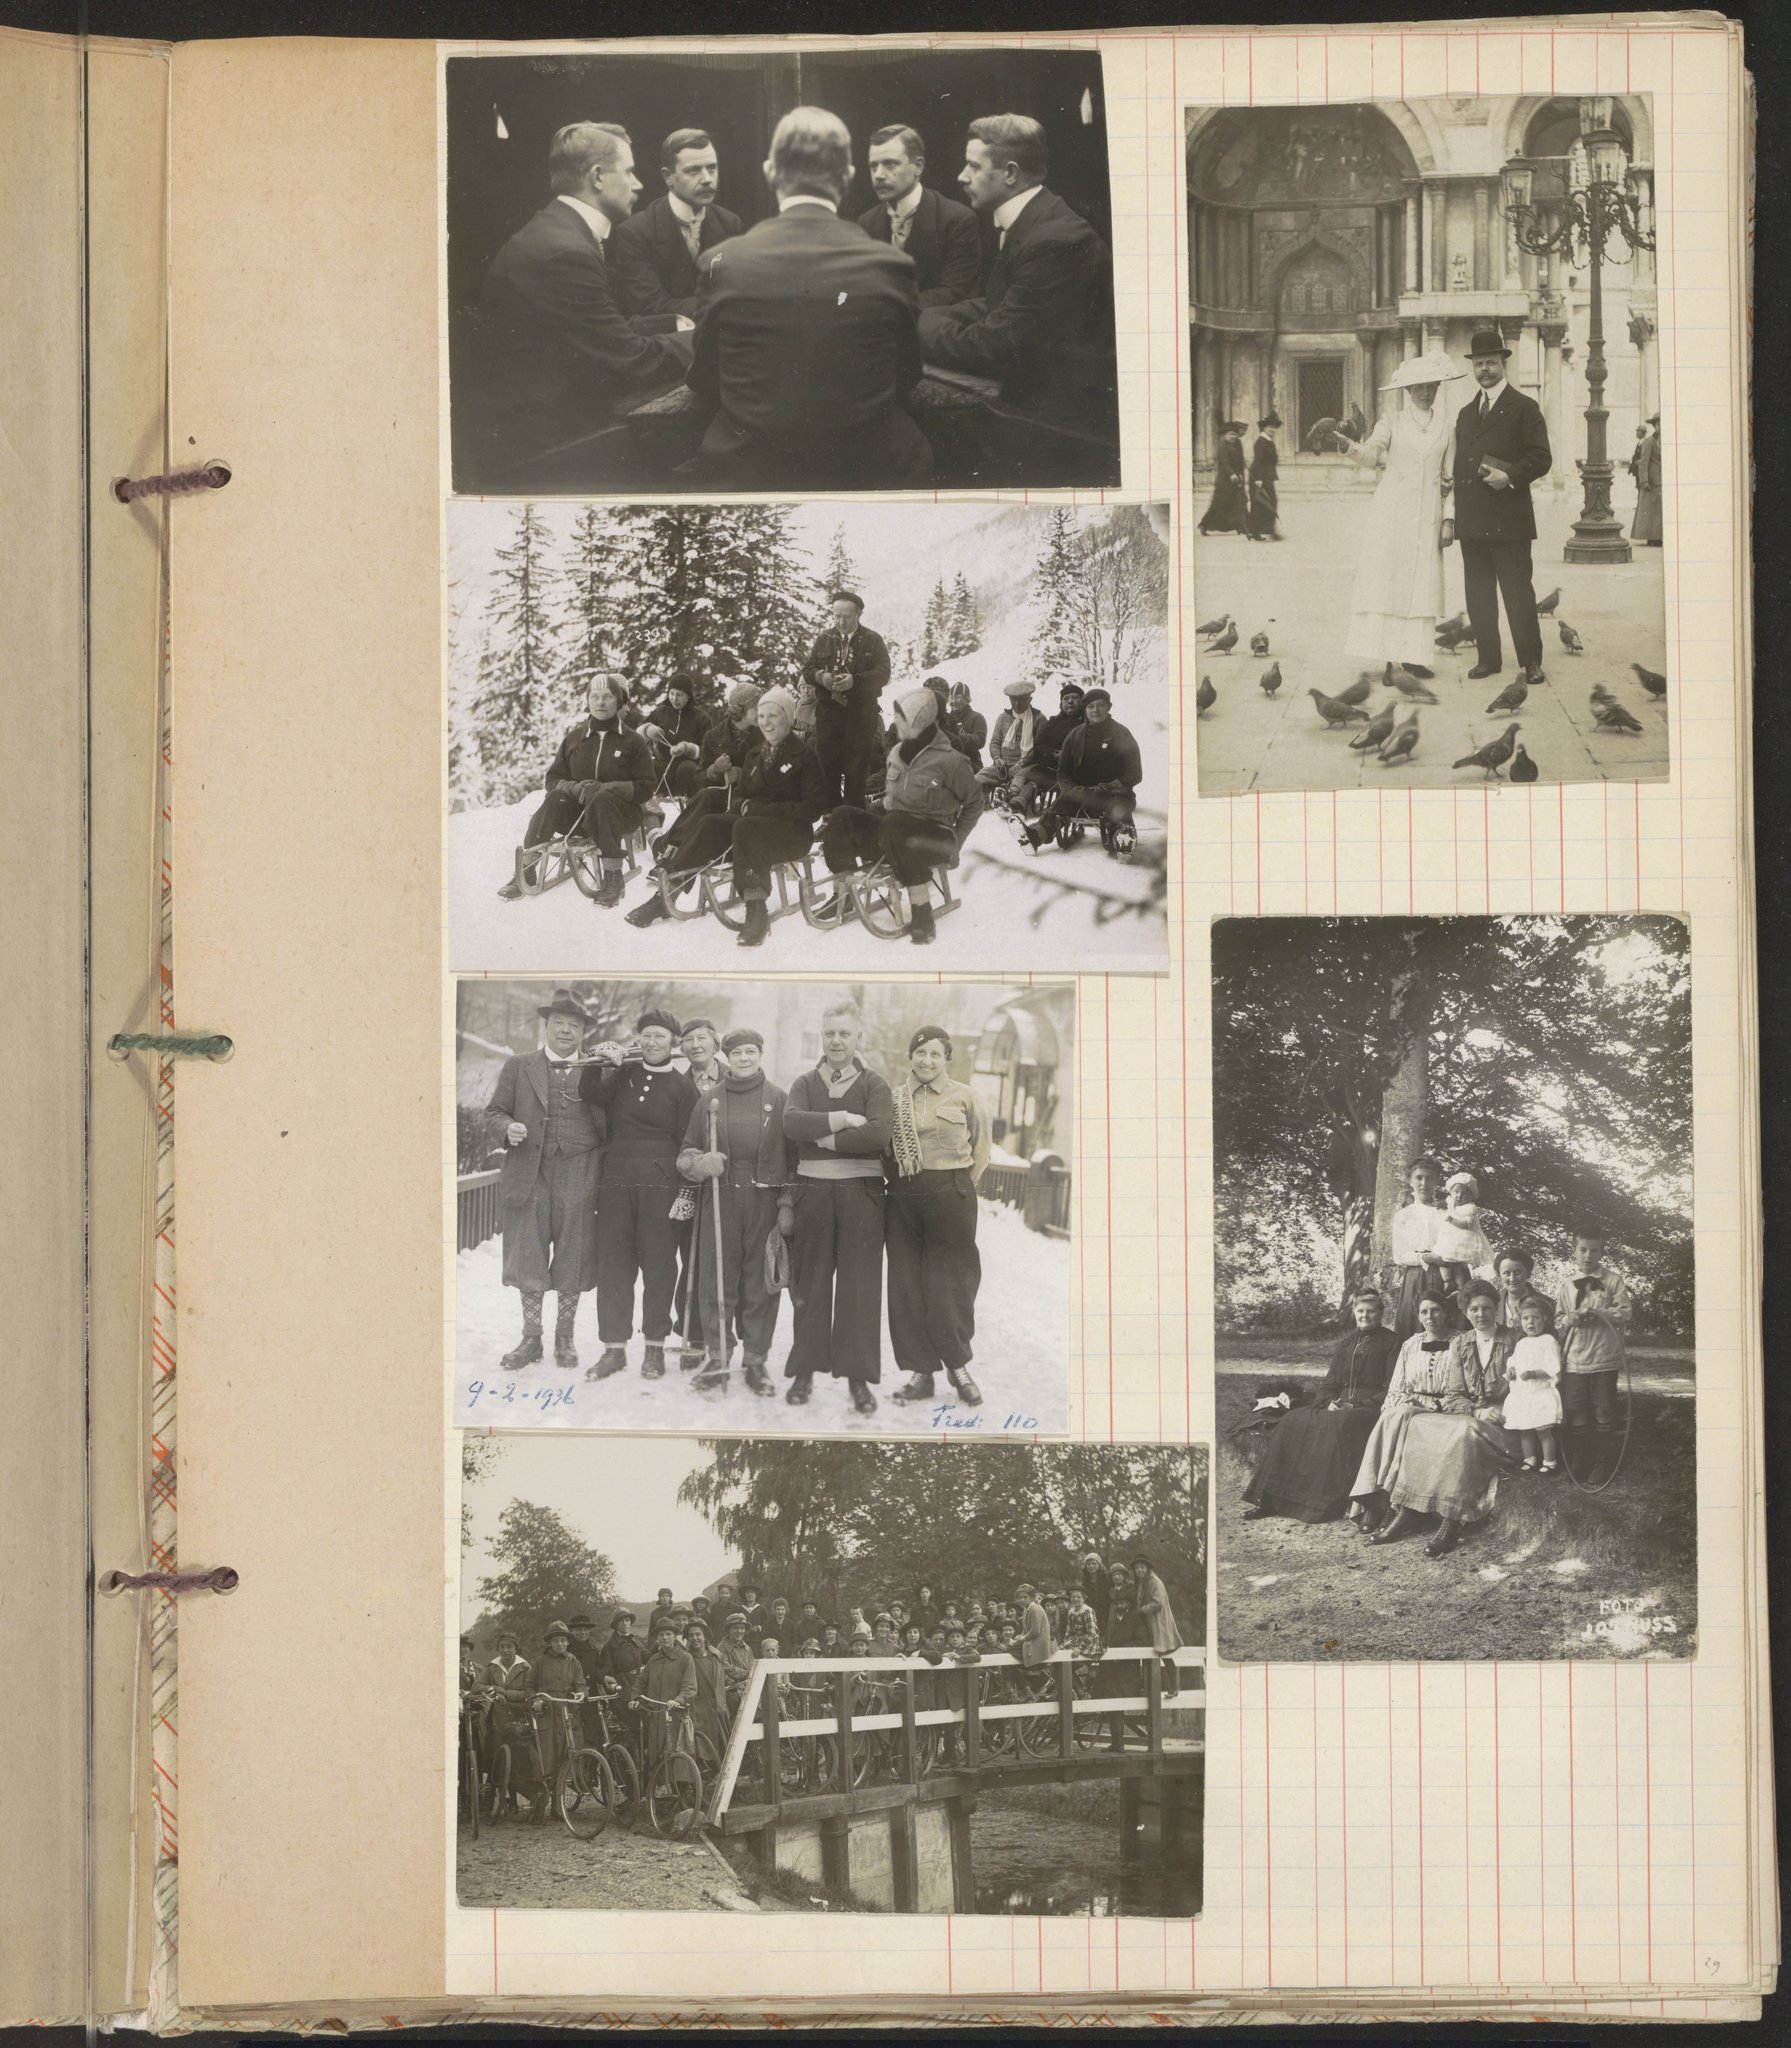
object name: photograph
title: Portretten van onbekende personen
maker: Anonymous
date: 1920-1940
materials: paper, photographic support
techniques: gelatin silver print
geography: europe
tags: skis (winter sports), adult woman, adult man, sledge, sleigh (winter sports)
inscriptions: inscription: ‘9-2-1936 fred: 110’, name: ‘Jos[...]uss’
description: Albumblad met groepsportretten: twee gezelschappen in de sneeuw, een groep fietsende vrouwen bij een brug, een familie onder een boom. Ook een man en een vrouw op het San Marcoplein in Venetië. Linksboven een opname met vijfmaal dezelfde man gezien via spiegels. Onderdeel van Fotoalbum van de familie Petri.